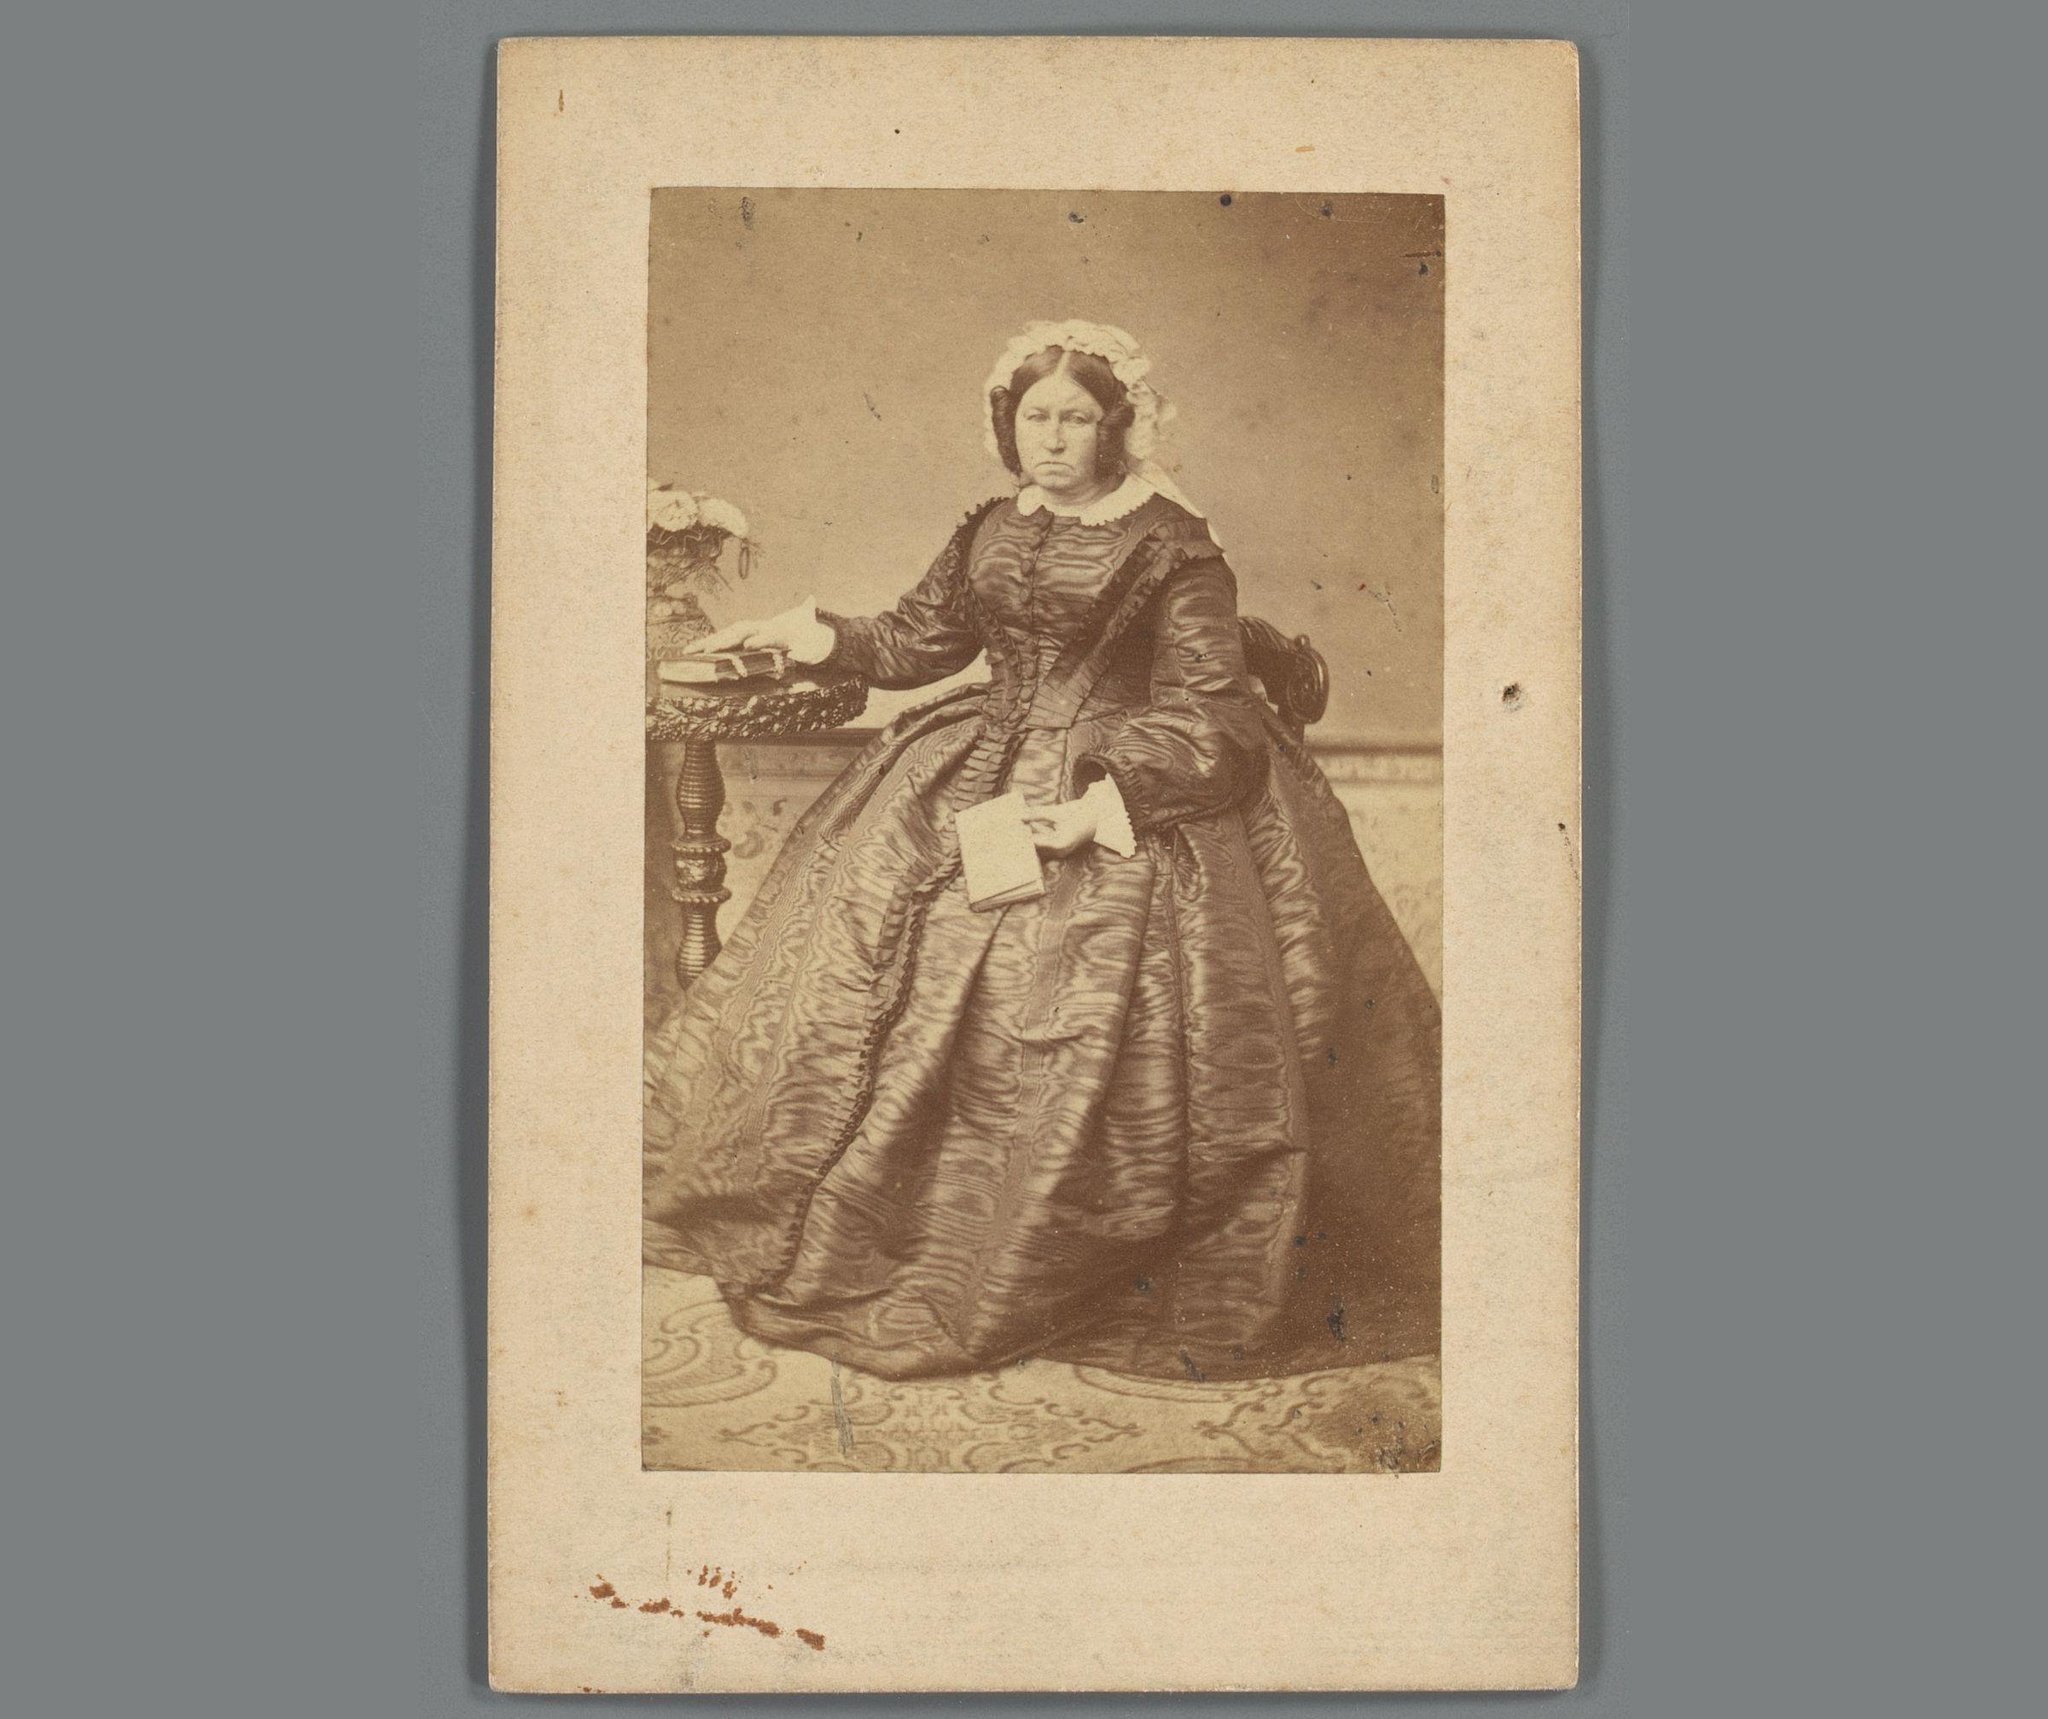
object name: prayer card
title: Portret van Elisabeth Marie Joséphine Mazeman de Couthove op bidprent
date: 1866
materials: cardboard, paper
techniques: albumen print, lithograph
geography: bruges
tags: adult woman, historical persons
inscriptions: inscription: ‘Priez pour l'Ame/ de Dame Elisabet-Marie-Jo'sephine/ Mazeman de Couthove (...) Lith. Daveluy, Bruges.’, inscription: ‘Br. M[...]’